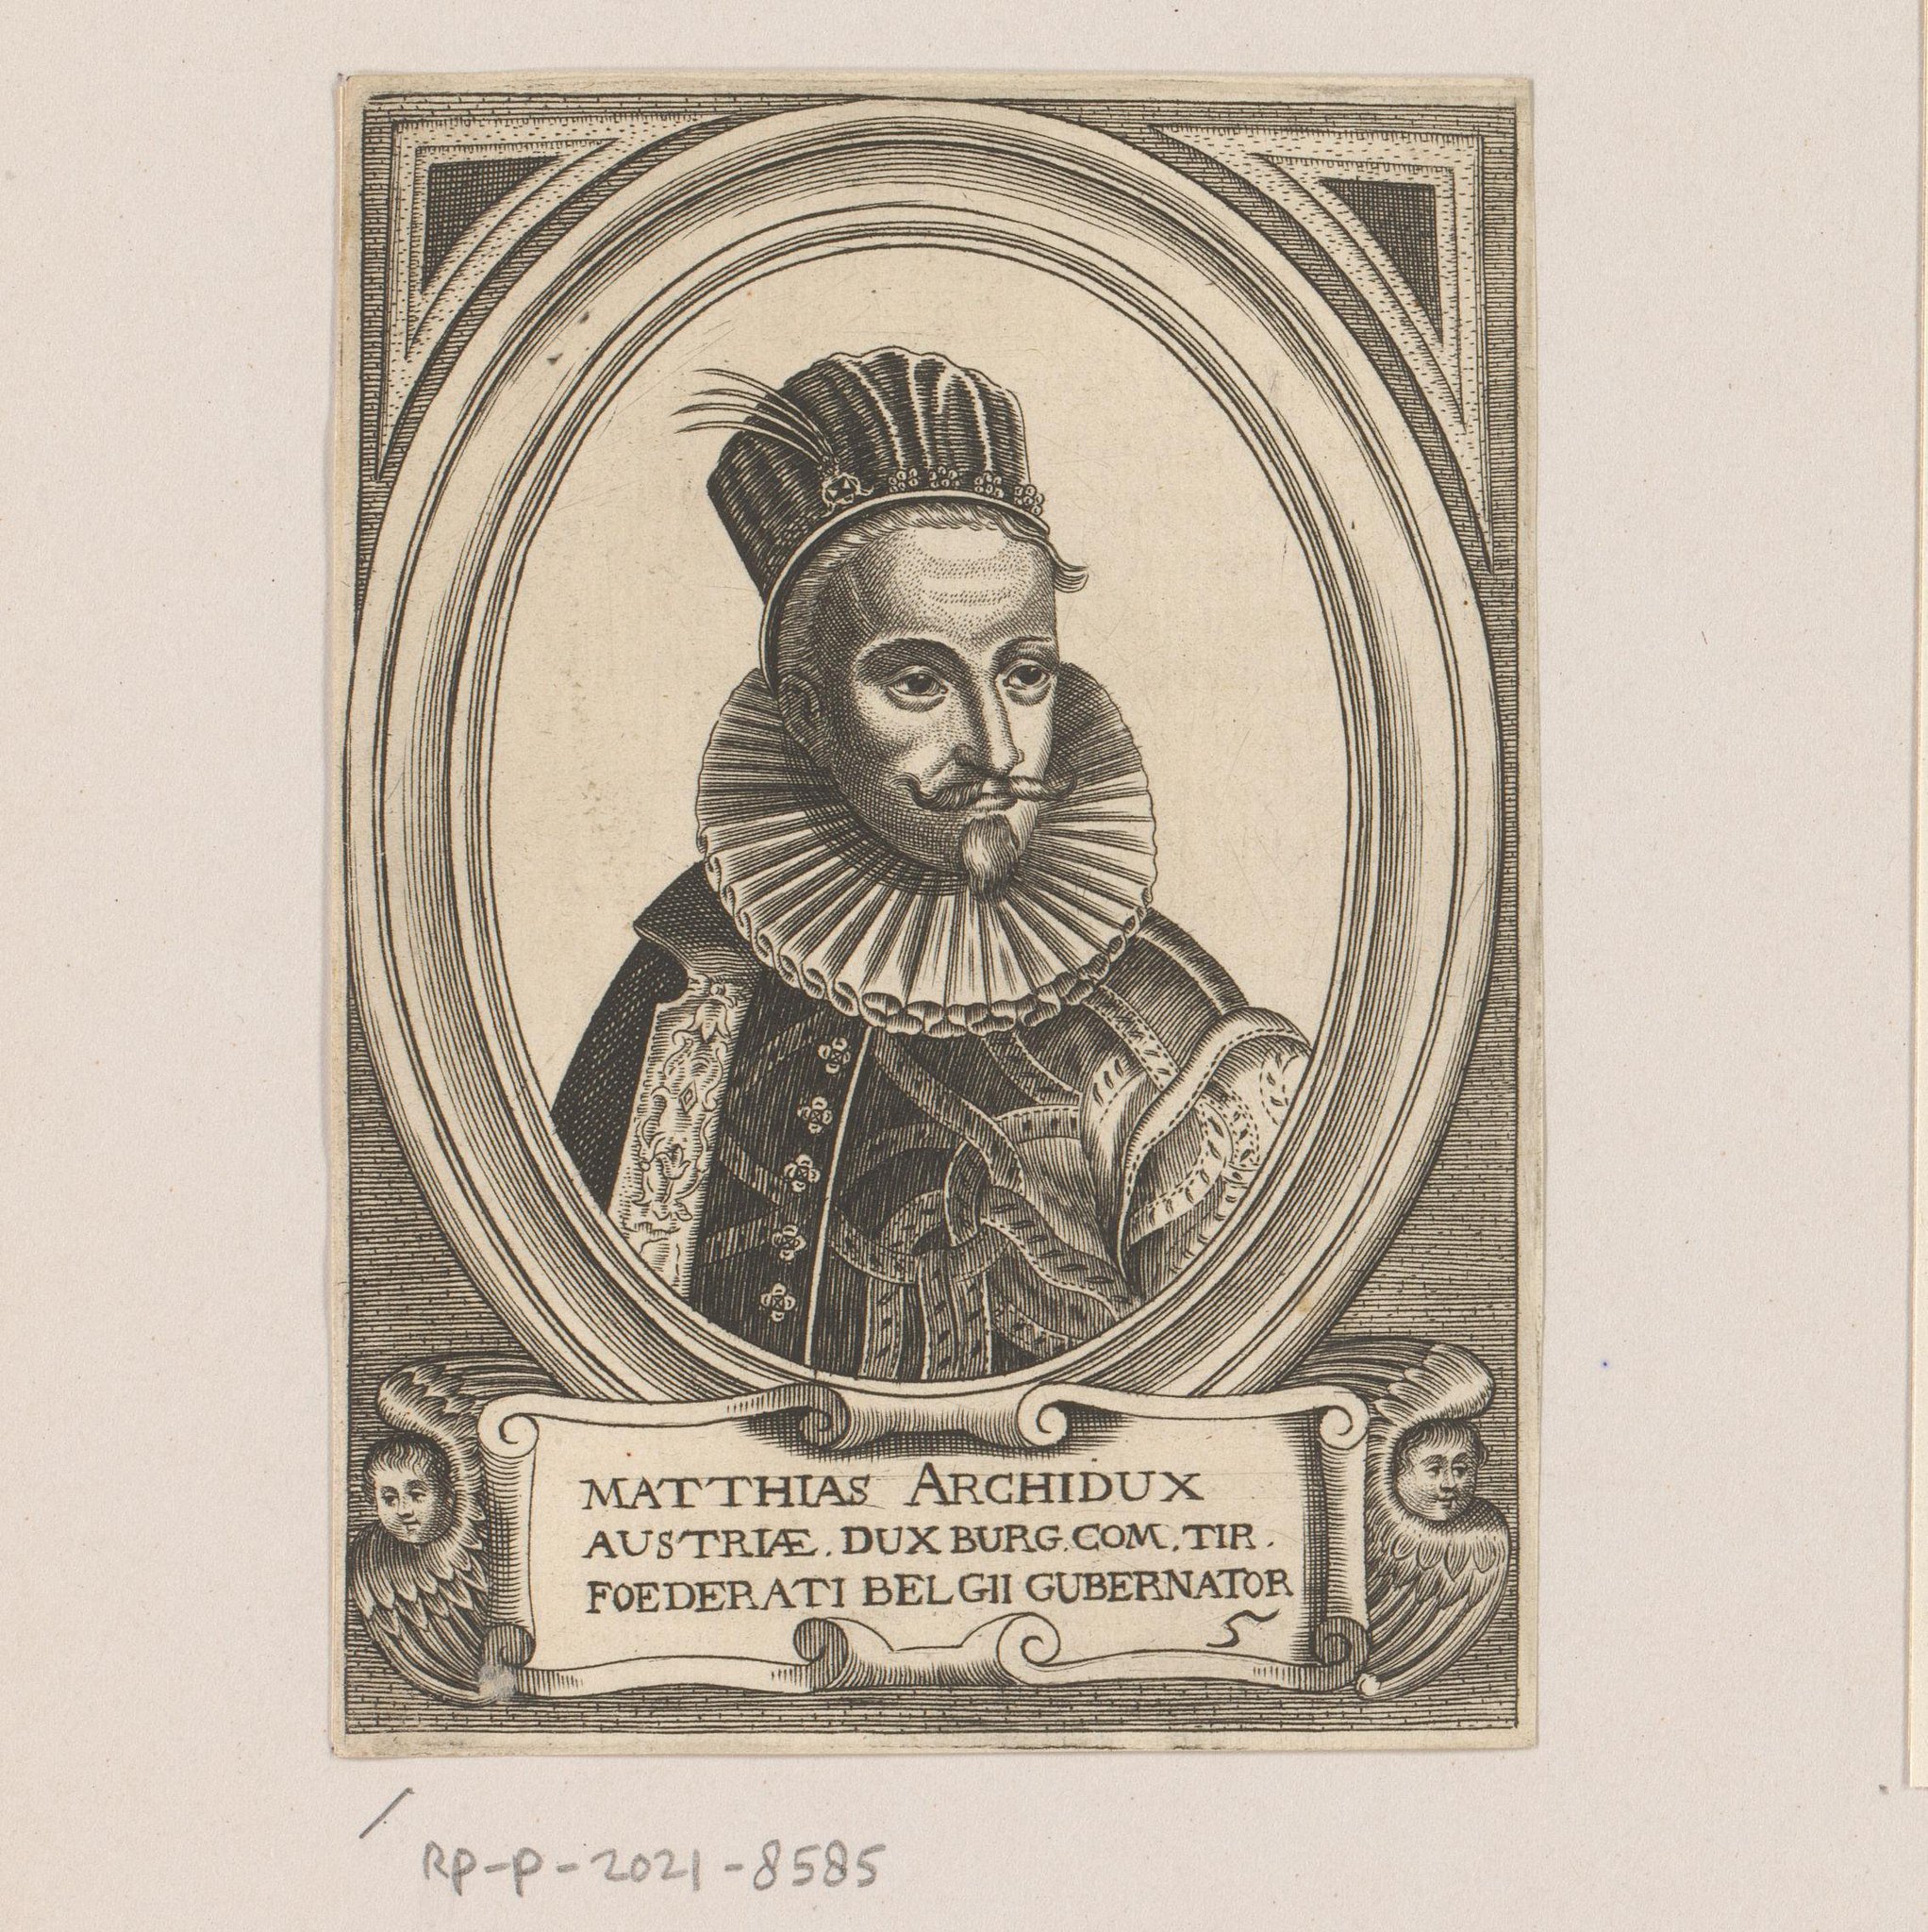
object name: print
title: Portret van keizer Matthias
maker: Anonymous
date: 1650-1750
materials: paper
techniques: engraving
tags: vienna, matthias van oostenrijk (rooms-duits keizer), ornament ~ medallion, historical persons, emperor